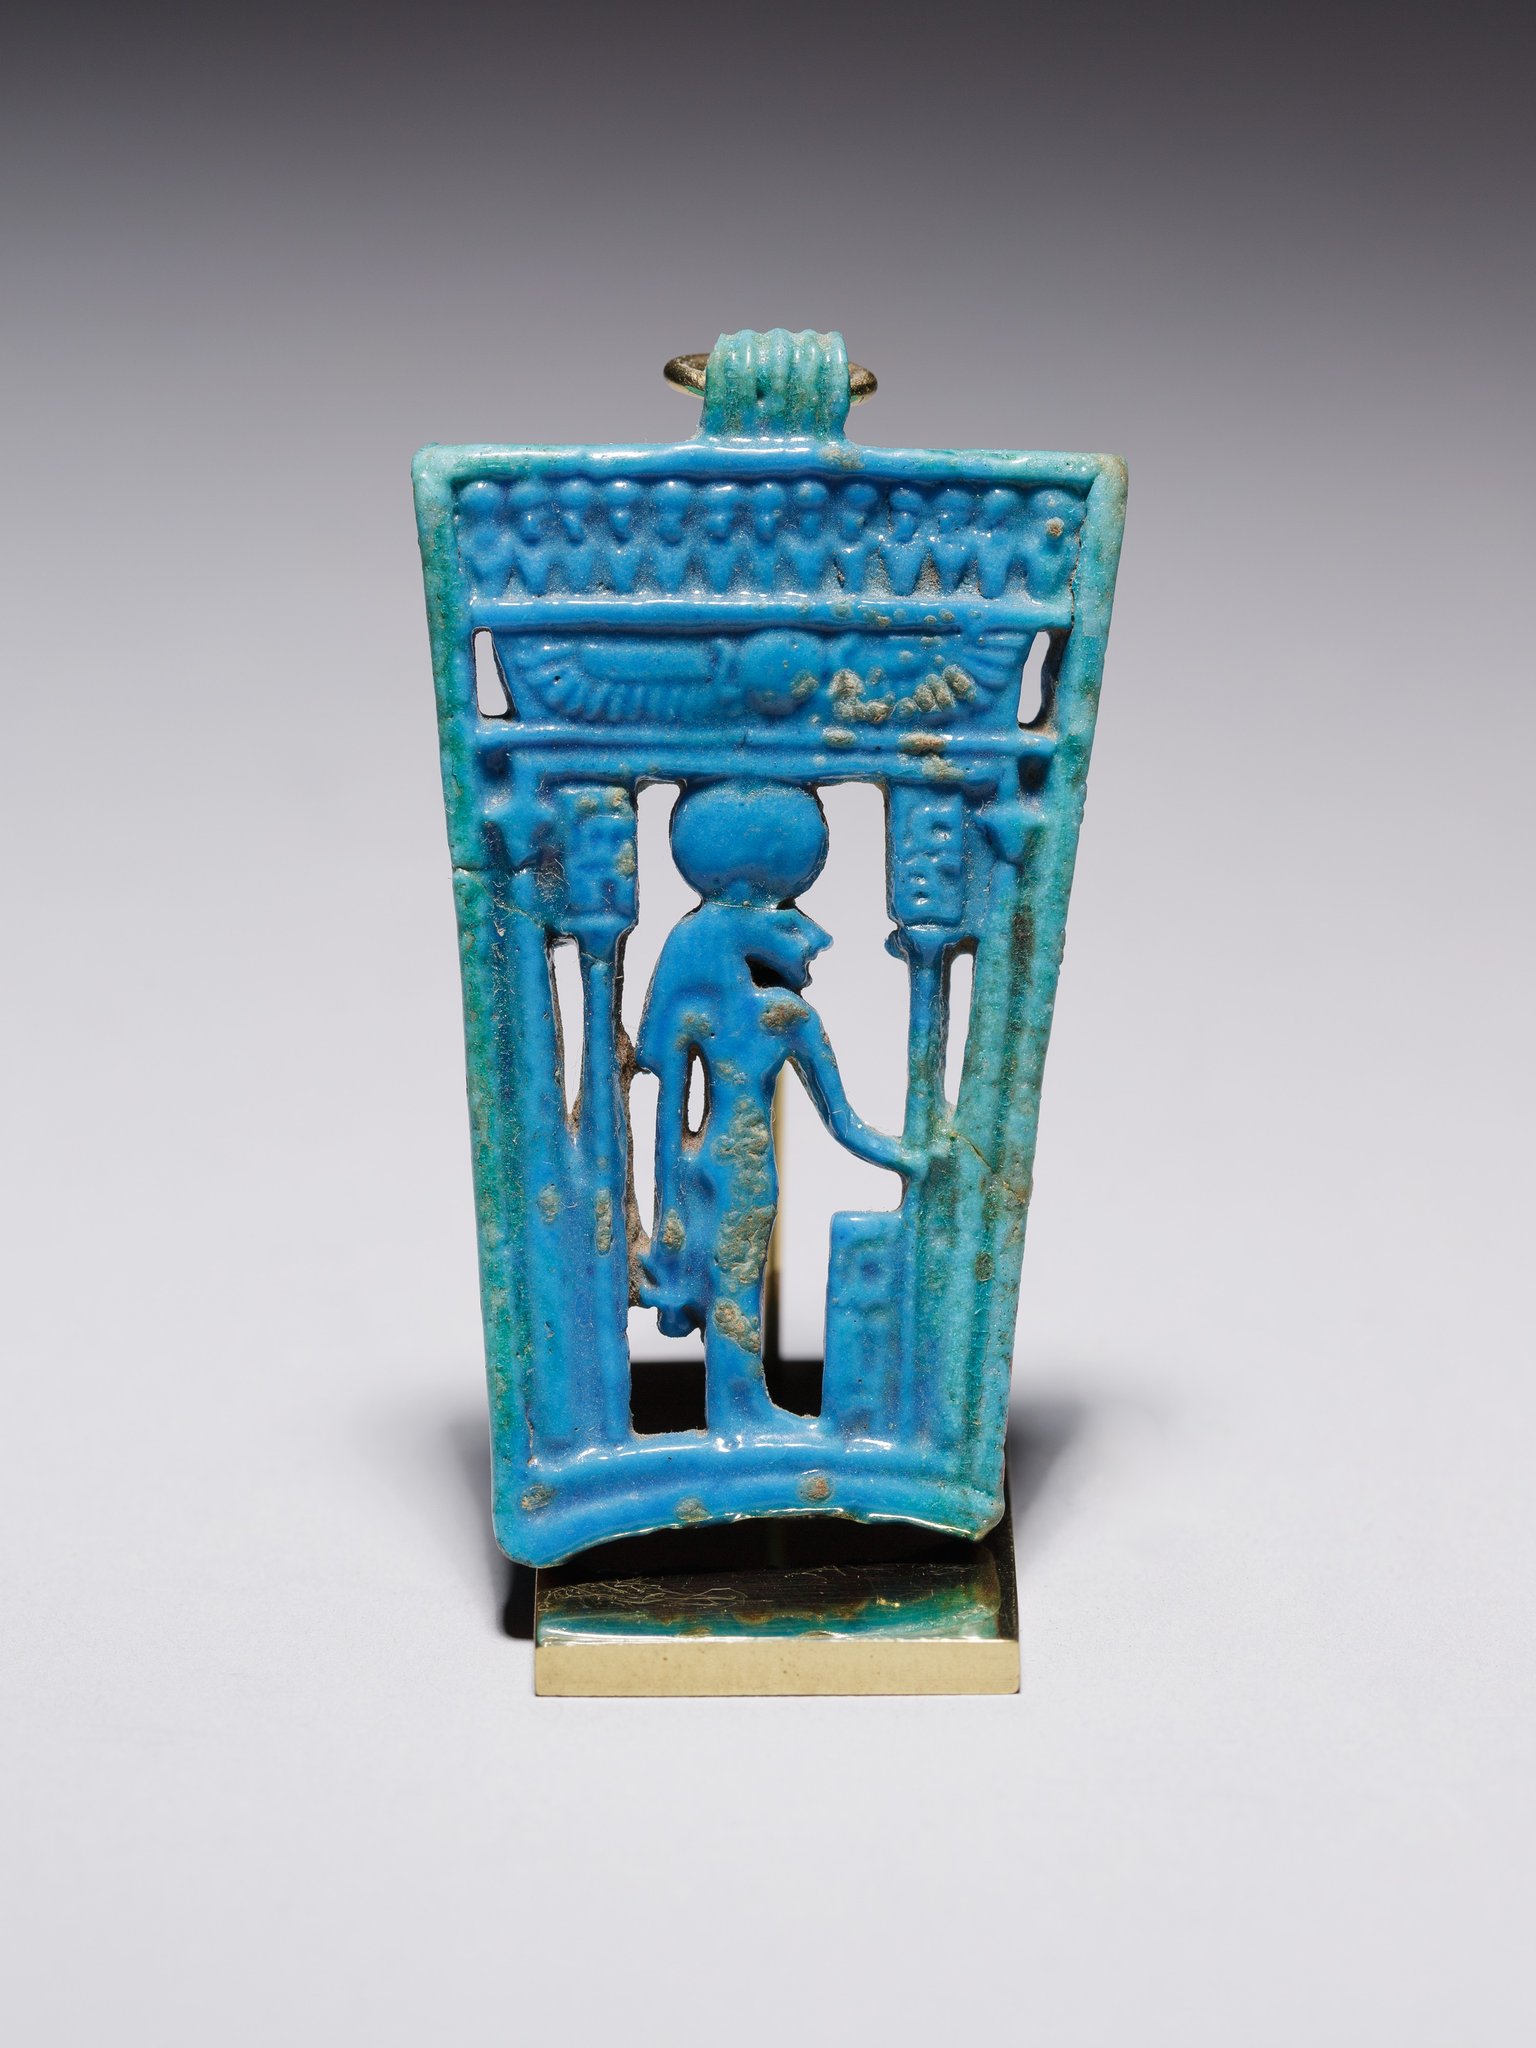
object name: menat counterpoise, bastet wadjet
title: Menat Counterpoise with an Image of Bastet?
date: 1070-664 BCE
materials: faience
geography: egypt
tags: goddess